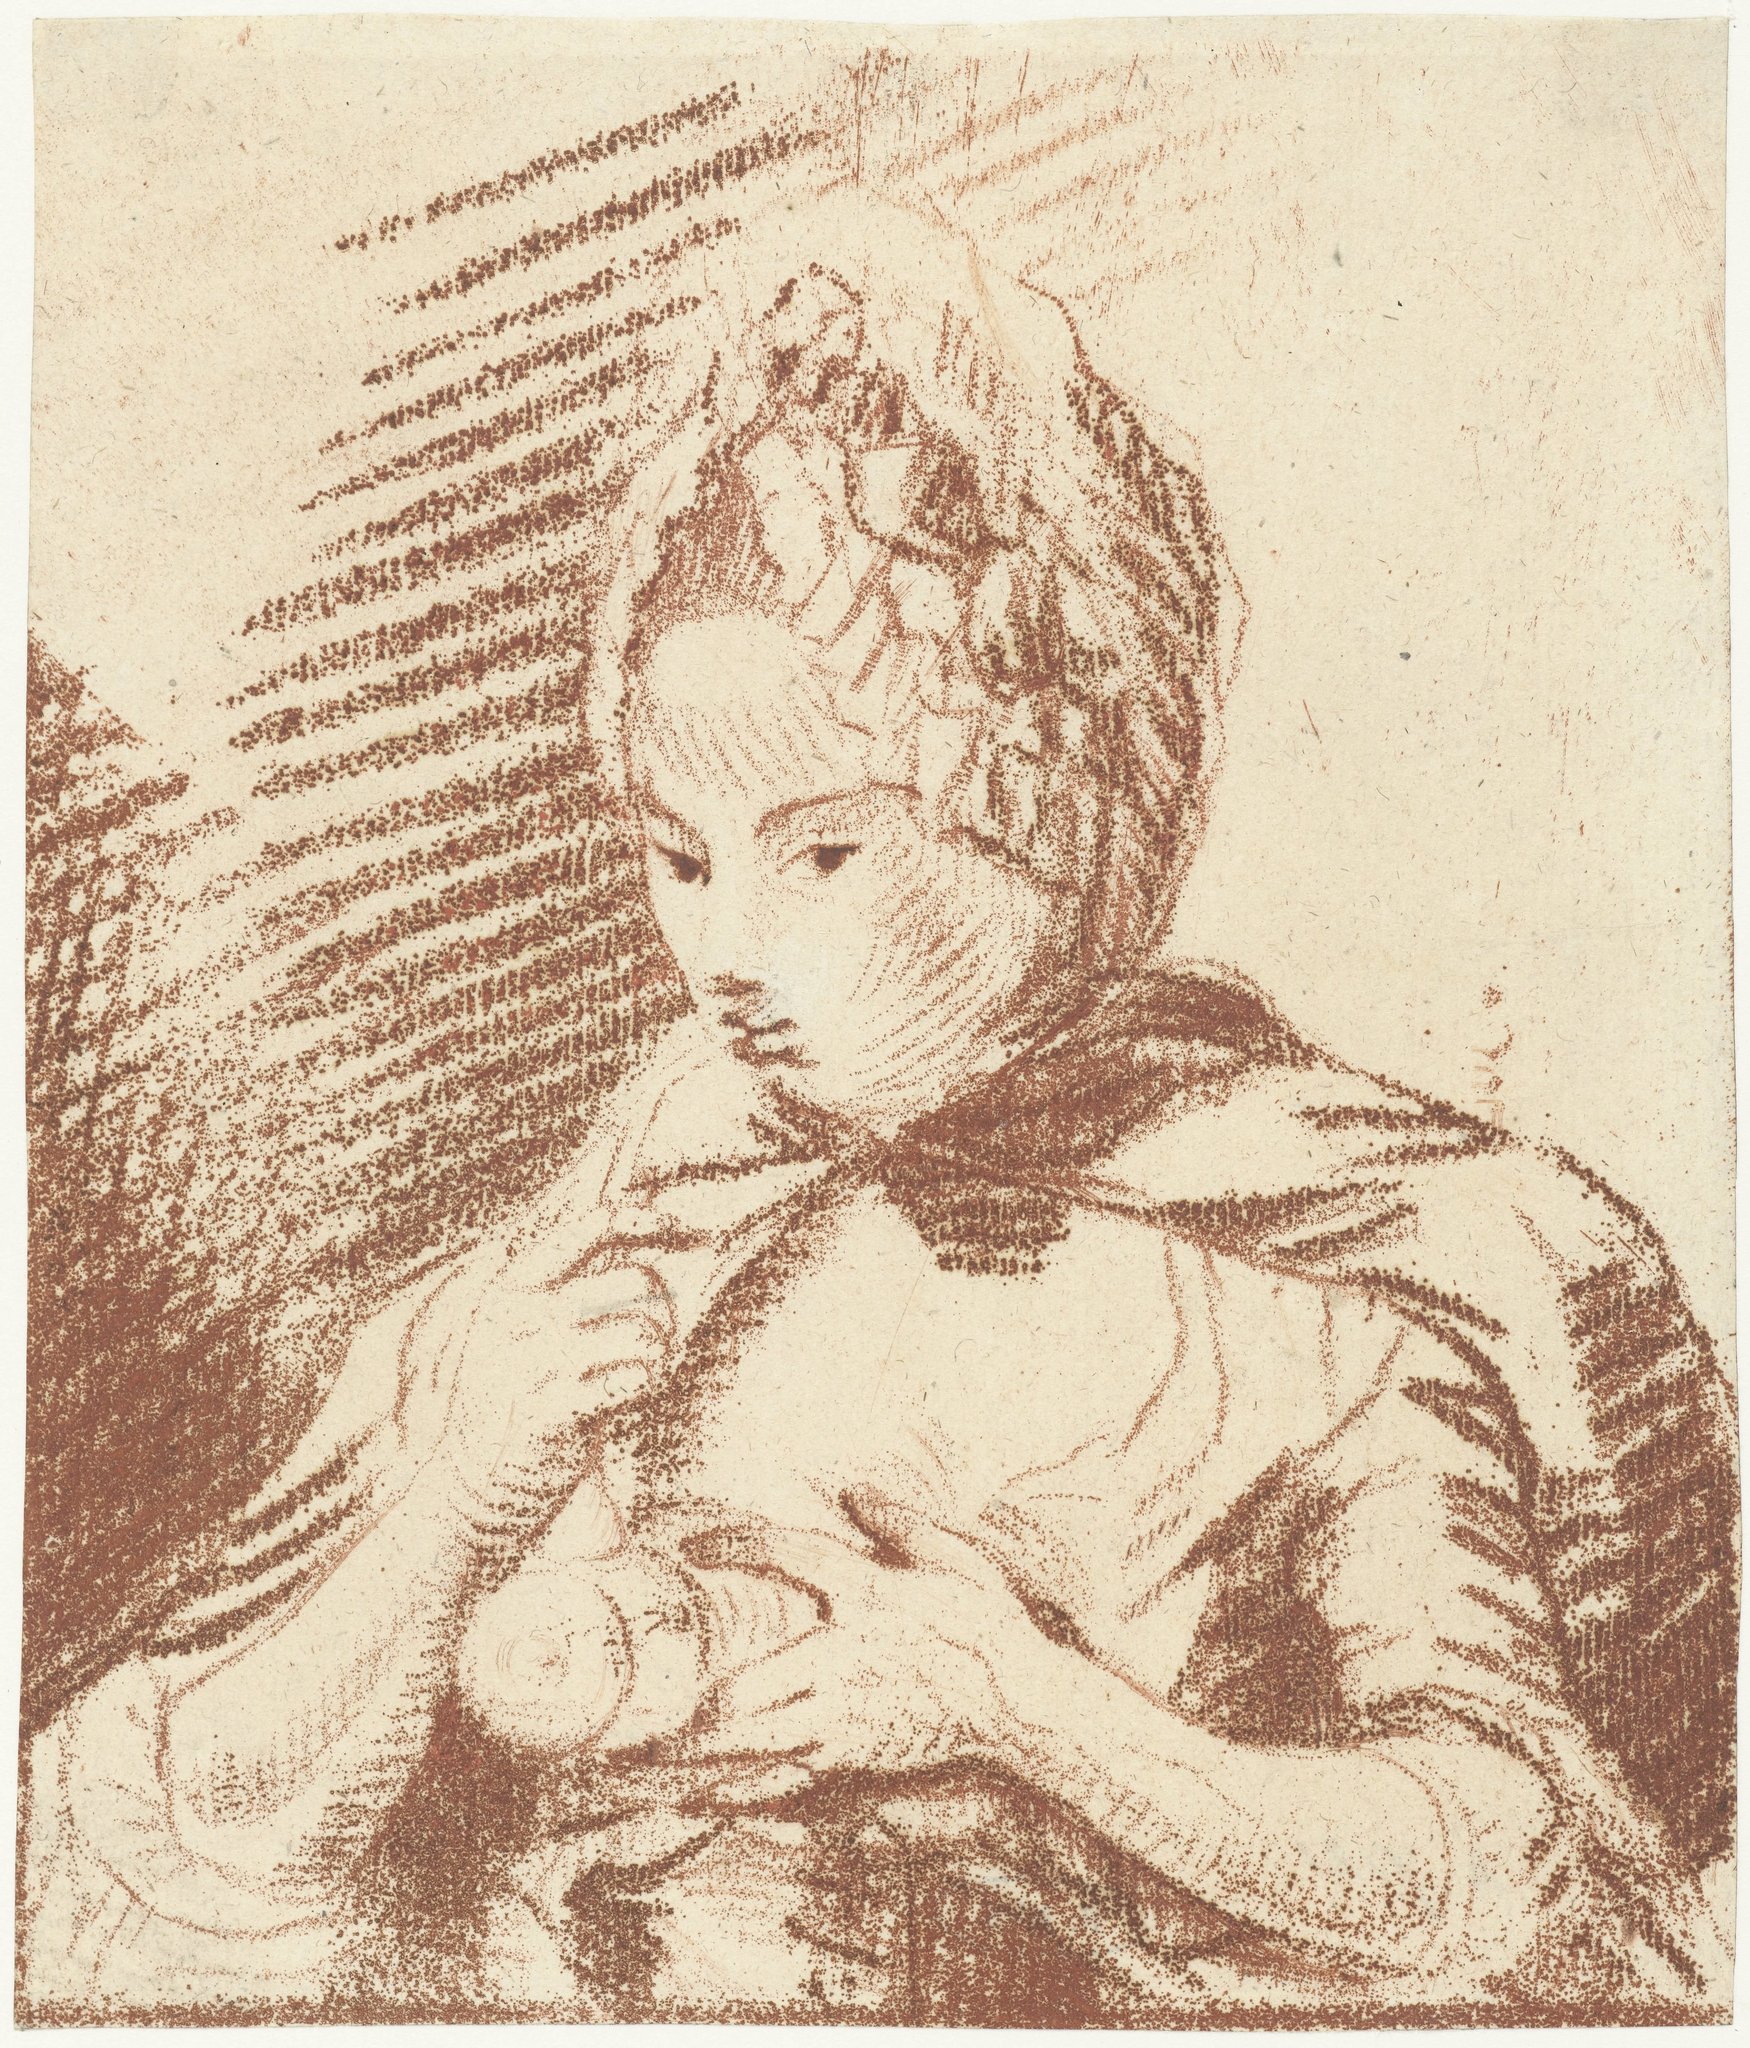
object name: print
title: Jonge moeder voedt haar kind met zuigfles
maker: louis bernard coclers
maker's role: draughtsman, print maker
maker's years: 1741-1817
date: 1756-1817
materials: paper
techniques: printmaking, etching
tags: head-gear: cap (+ women's clothes), feeding a baby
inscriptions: collector's mark: Lugt 2228